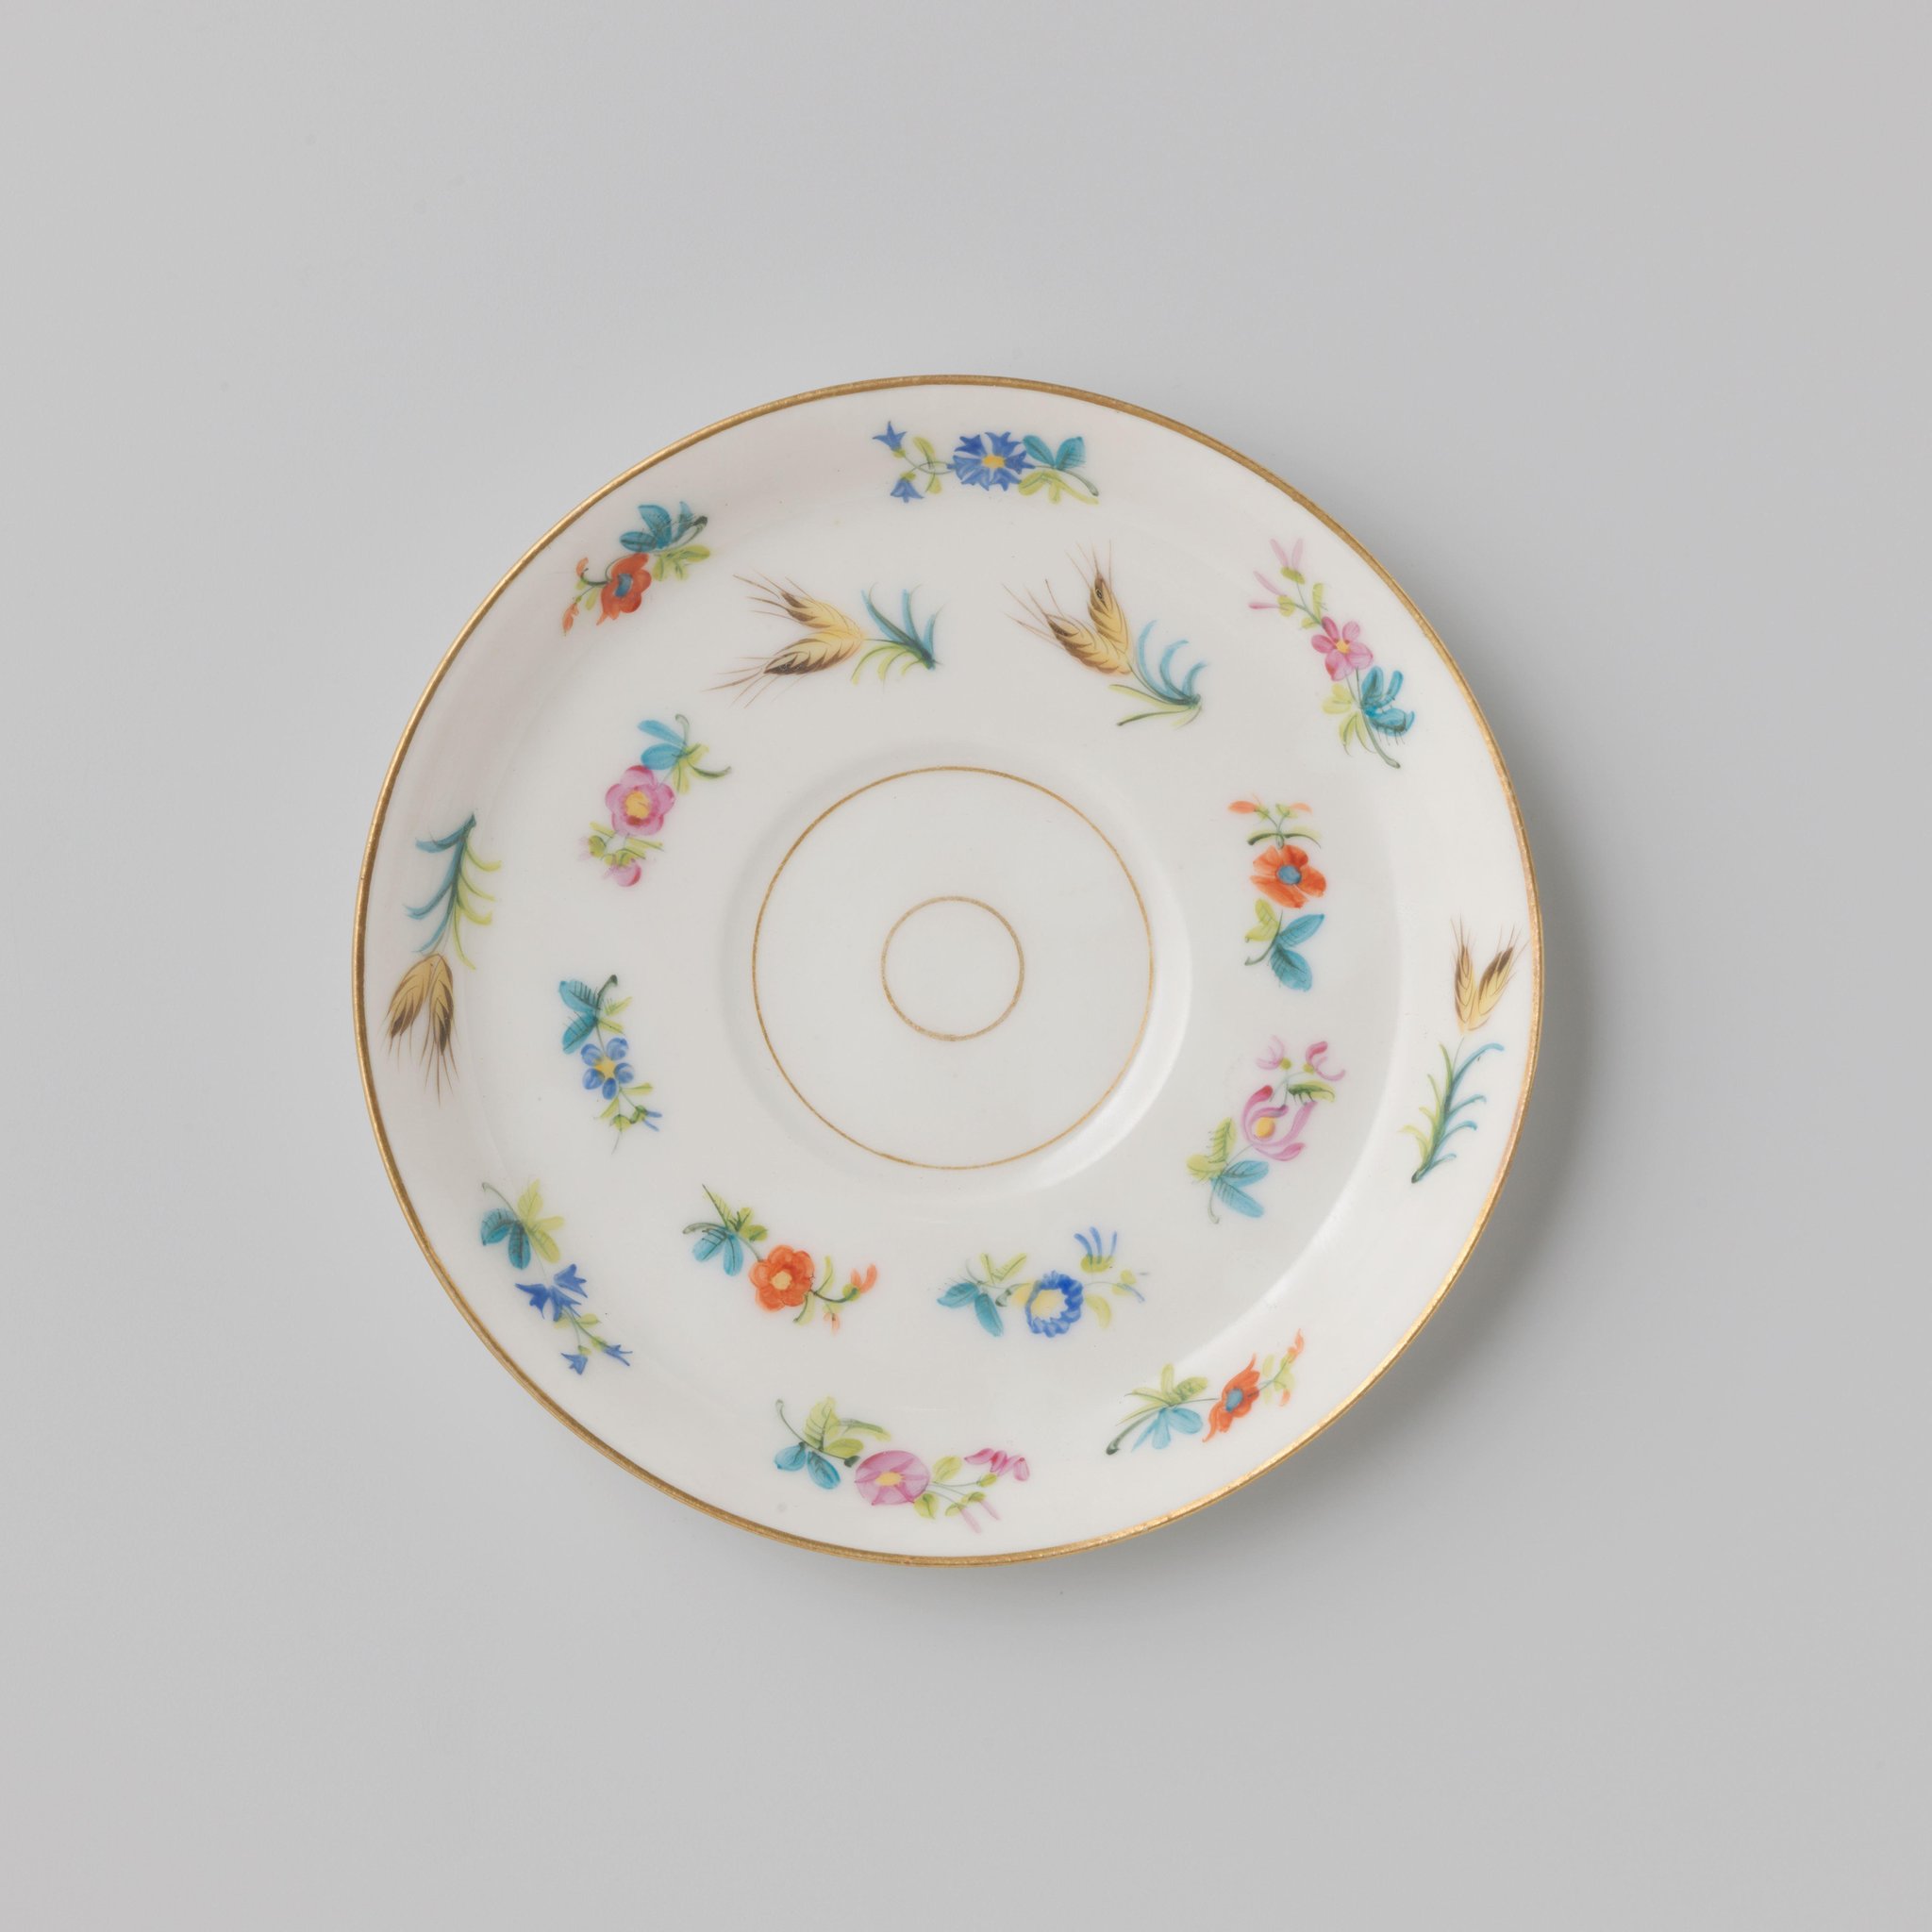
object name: service set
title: Saucer with flower sprays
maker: Anonymous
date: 1860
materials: glaze, gold, paint, porcelain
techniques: firing, forming, gilding, turning, vitrification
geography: france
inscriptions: mark: ‘II/ I6[?]II’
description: Schotel van porselein, beschilderd op het glazuur in blauw, rood, roze, groen, geel, bruin en goud. Op het plat een dubbele gouden cirkel met daaromheen en op de binnenwand een band van bloemtakken. Gouden rand. Drie proenen op de onderzijde. Gemerkt op de onderzijde met II en I6[?]II.